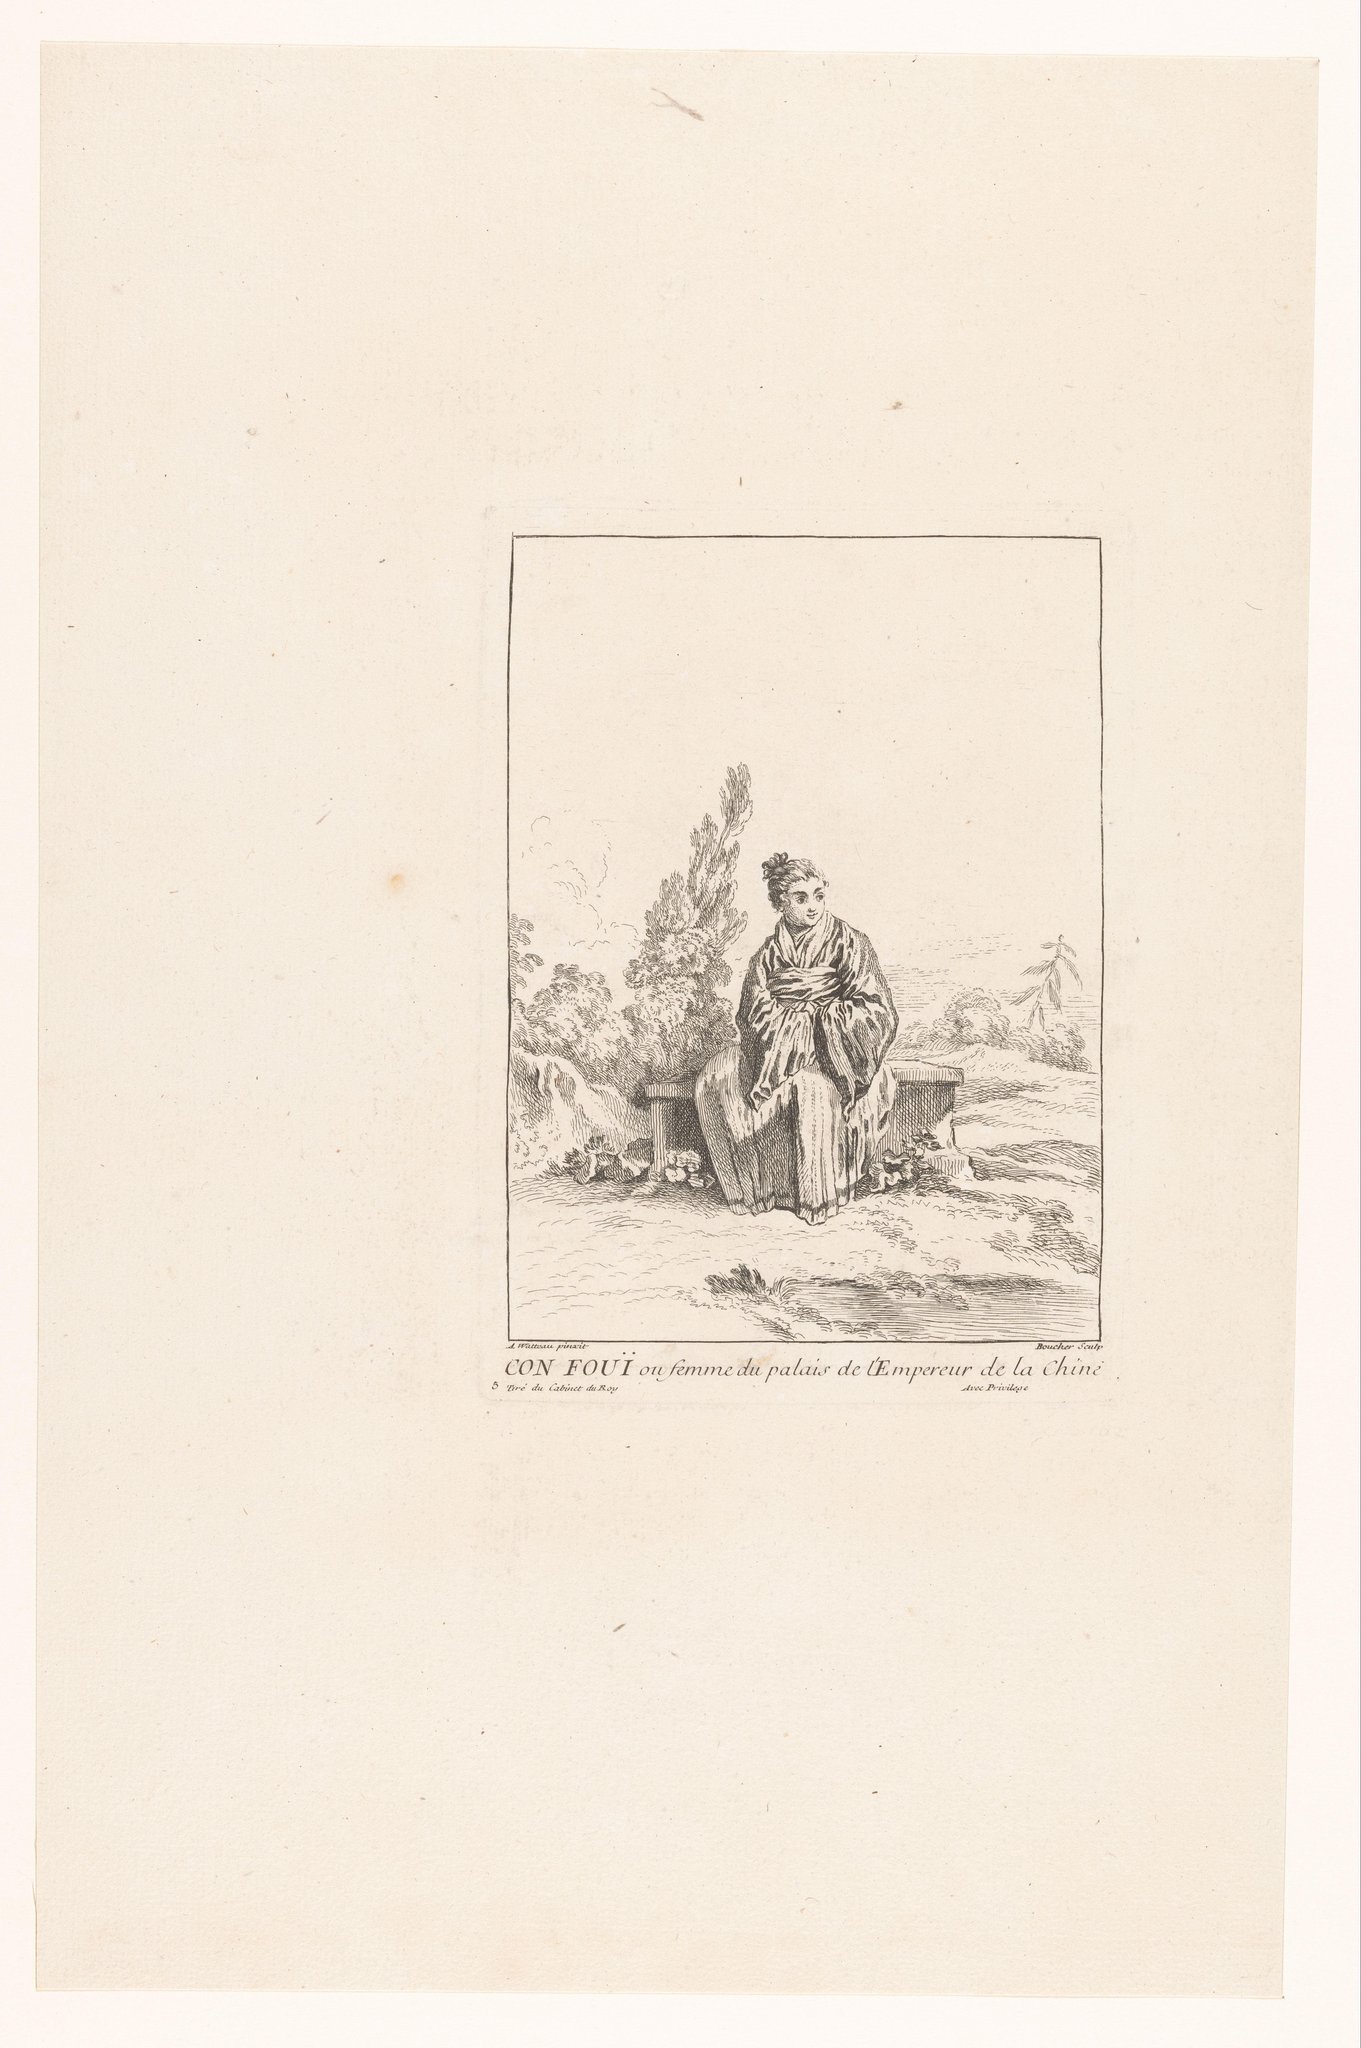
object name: print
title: Verschillende Chinese en Tartaarse figuren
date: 1731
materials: paper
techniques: etching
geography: paris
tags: sitting figure - aa - female human figure, chinese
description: Maakt deel uit van een serie van 271 platen, inclusief twee titelprenten, naar schilderijen door Watteau en verzameld door Jean de Jullienne. Sommige platen werden reeds tijdens Watteau's leven vervaardigd en de rest kwam pas na zijn dood tot stand. In 1734 werd het eind van de serie aangekondigd. Deze plaat betreft nr. 240 van de serie. Maakt eveneens deel uit van een subgroep van twaalf prenten, getiteld 'Diverses Figures Chinoises et Tartares Peintes par Watteau (...)'.